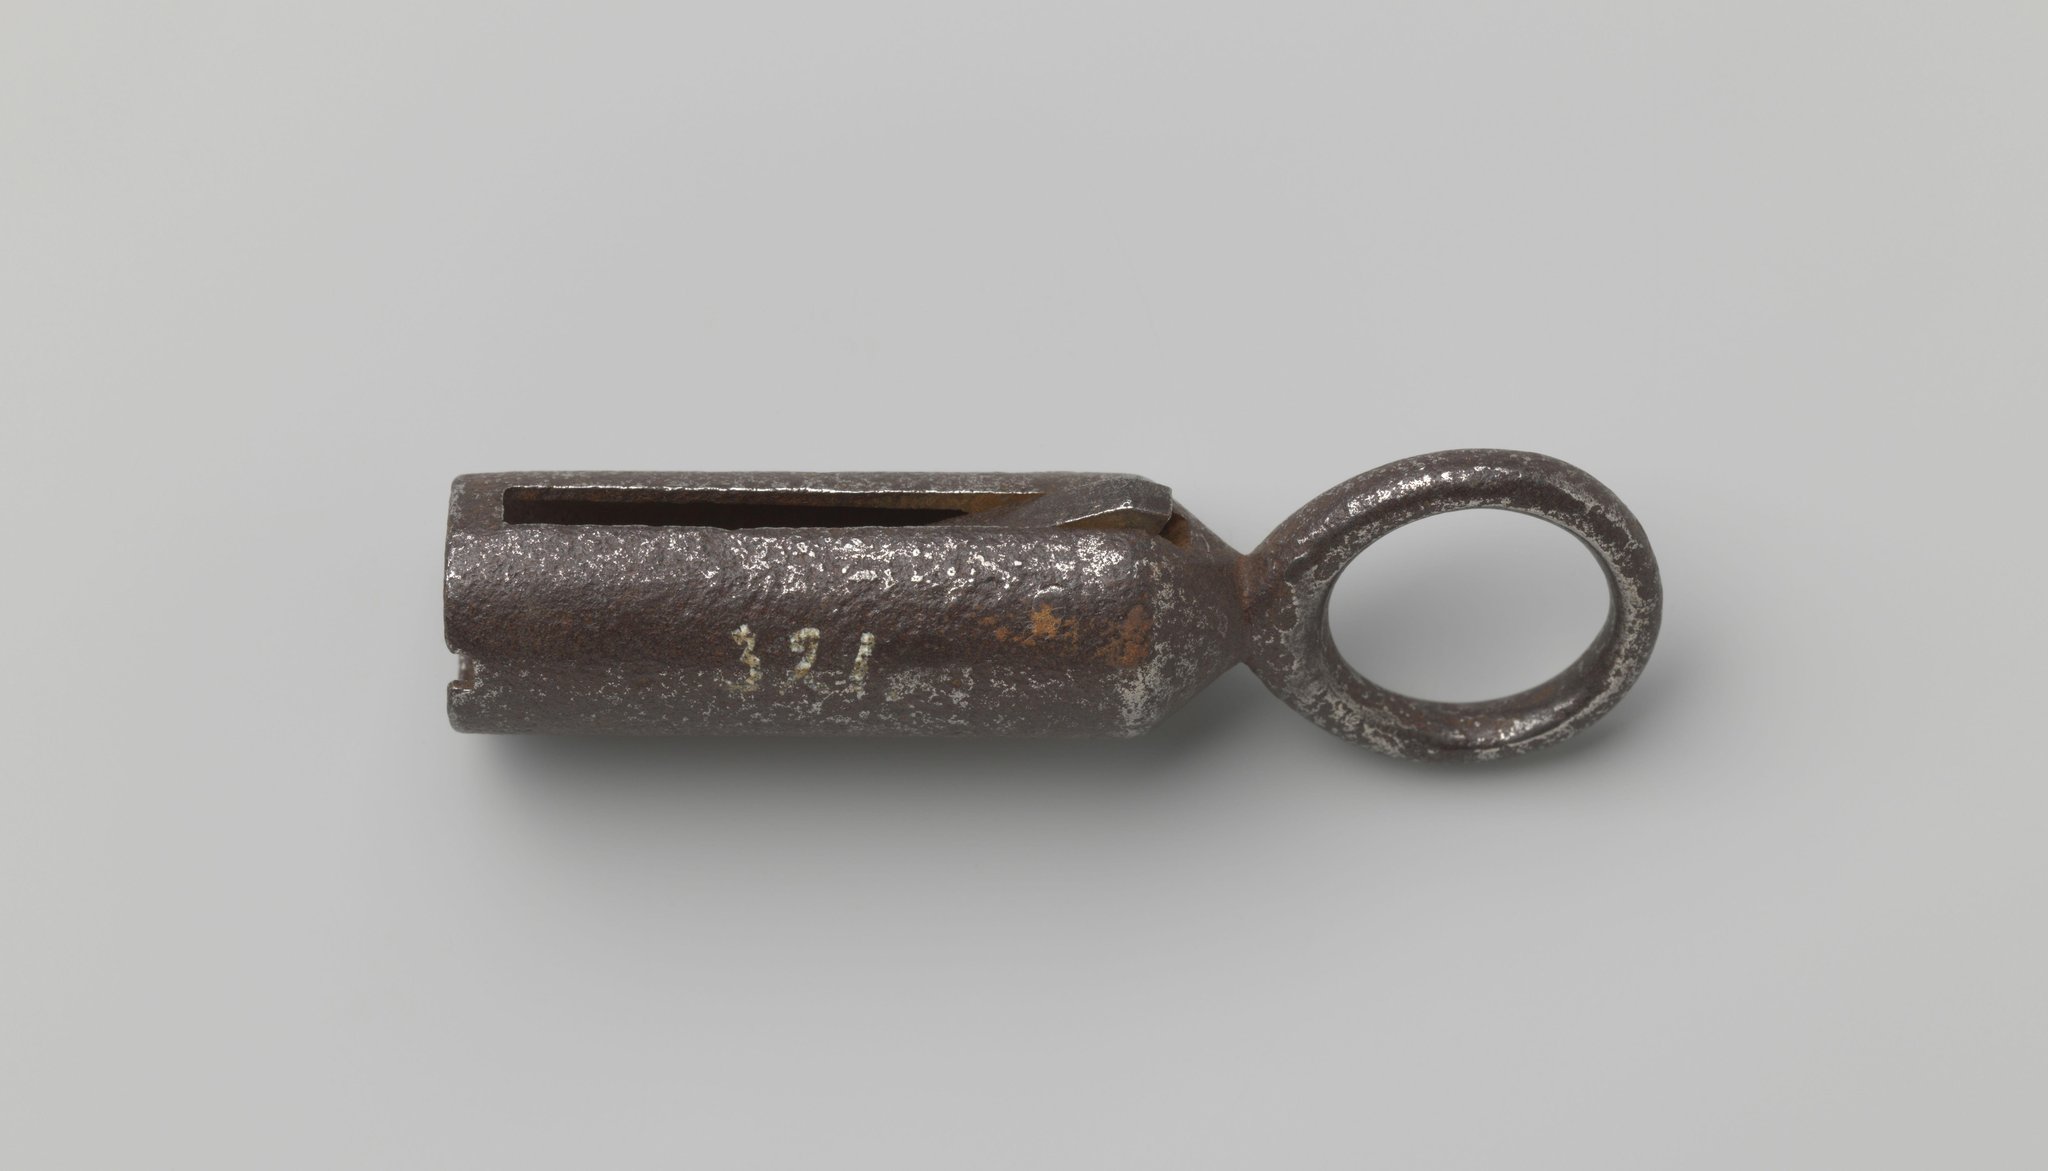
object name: key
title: Sleutel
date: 1800-1900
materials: iron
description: Sleutel, waarvan de baard door een cylindervormige omhulling wordt omgeven en beweegbaar is. Het oog is ringvormig.